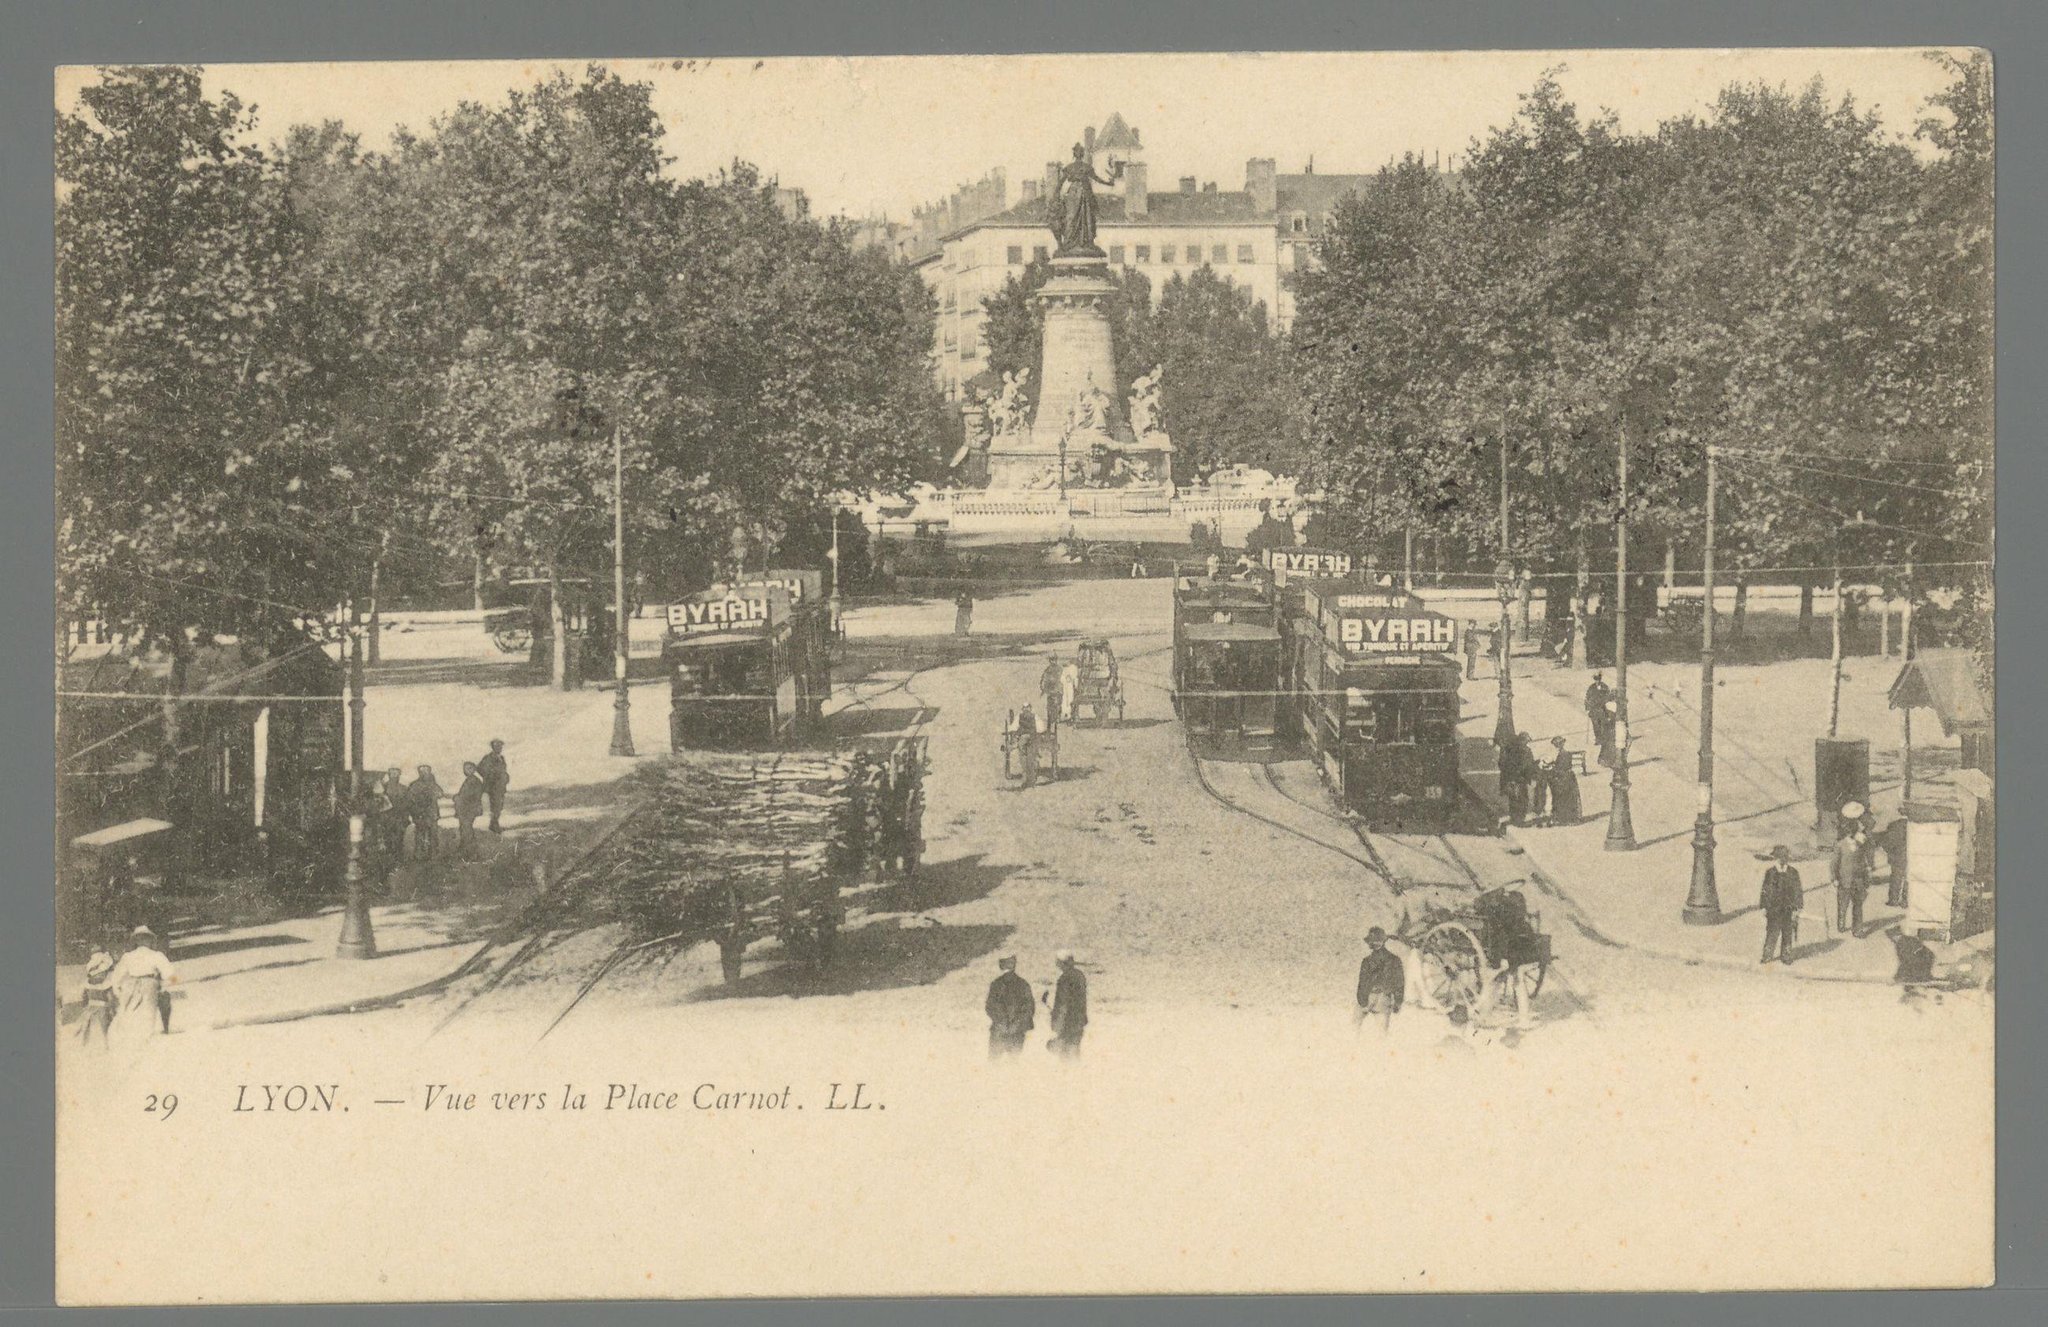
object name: photomechanical print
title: Lyon. Vue vers la Place Carnot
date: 1895-1903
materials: cardboard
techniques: photograph, writing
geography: paris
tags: monument, statue, square, place, circus, etc. (+ city(-scape) with figures, staffage)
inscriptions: postage stamp